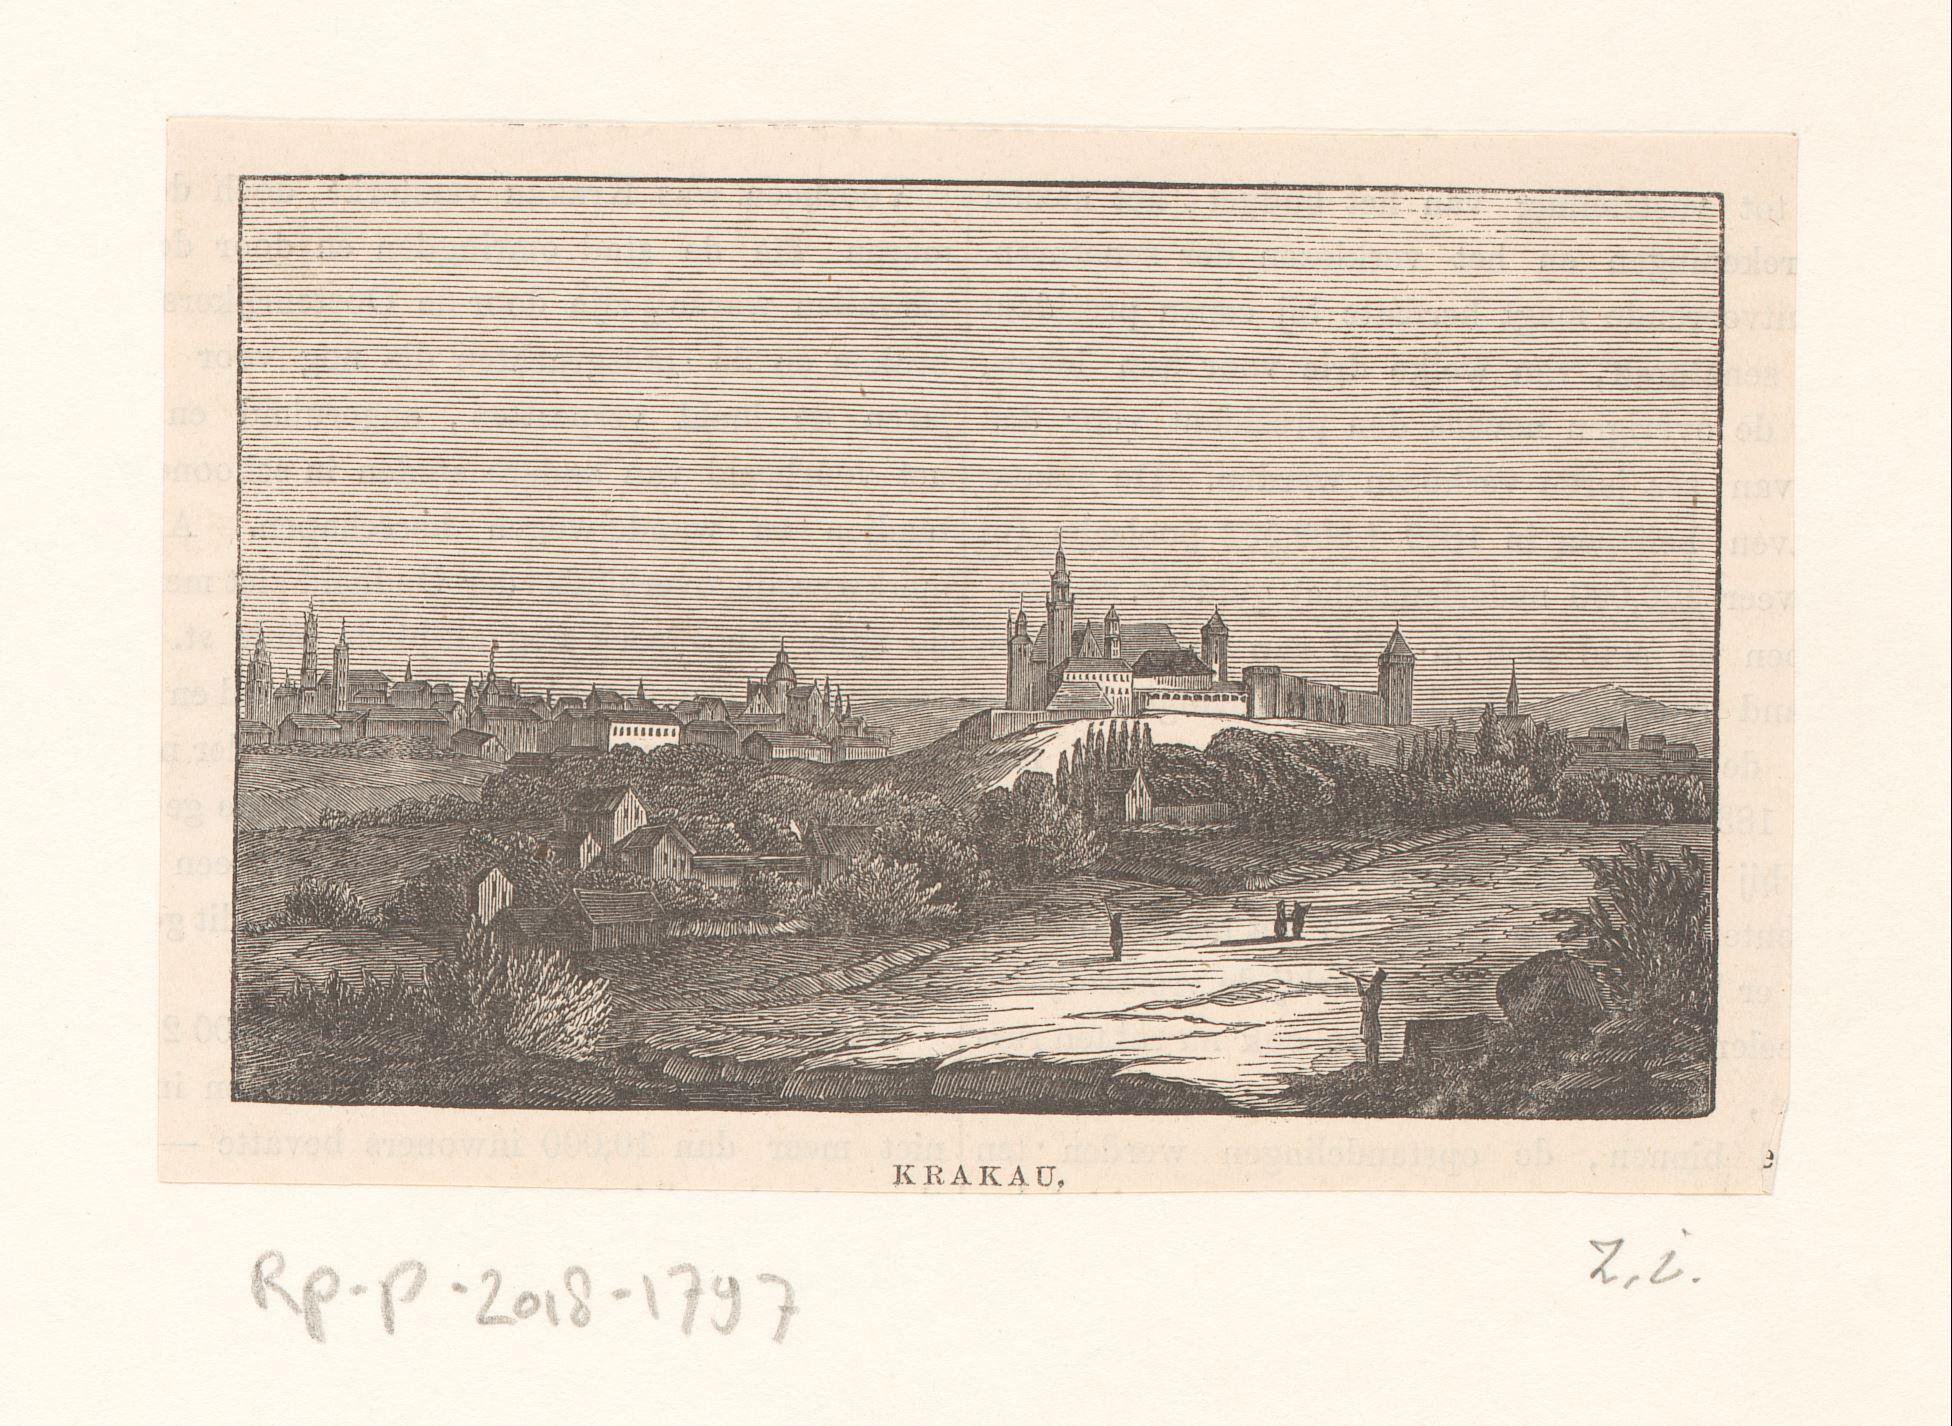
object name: book illustration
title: Gezicht op Krakau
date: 1847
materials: paper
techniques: letterpress printing, engraving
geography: amsterdam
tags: prospect of city, town panorama, silhouette of city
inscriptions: collector's mark: Lugt 2228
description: Prent gebruikt in: Hollandsch Penning-Magazijn voor de jeugd. Amsterdam: J.H. Laarman, 1847.